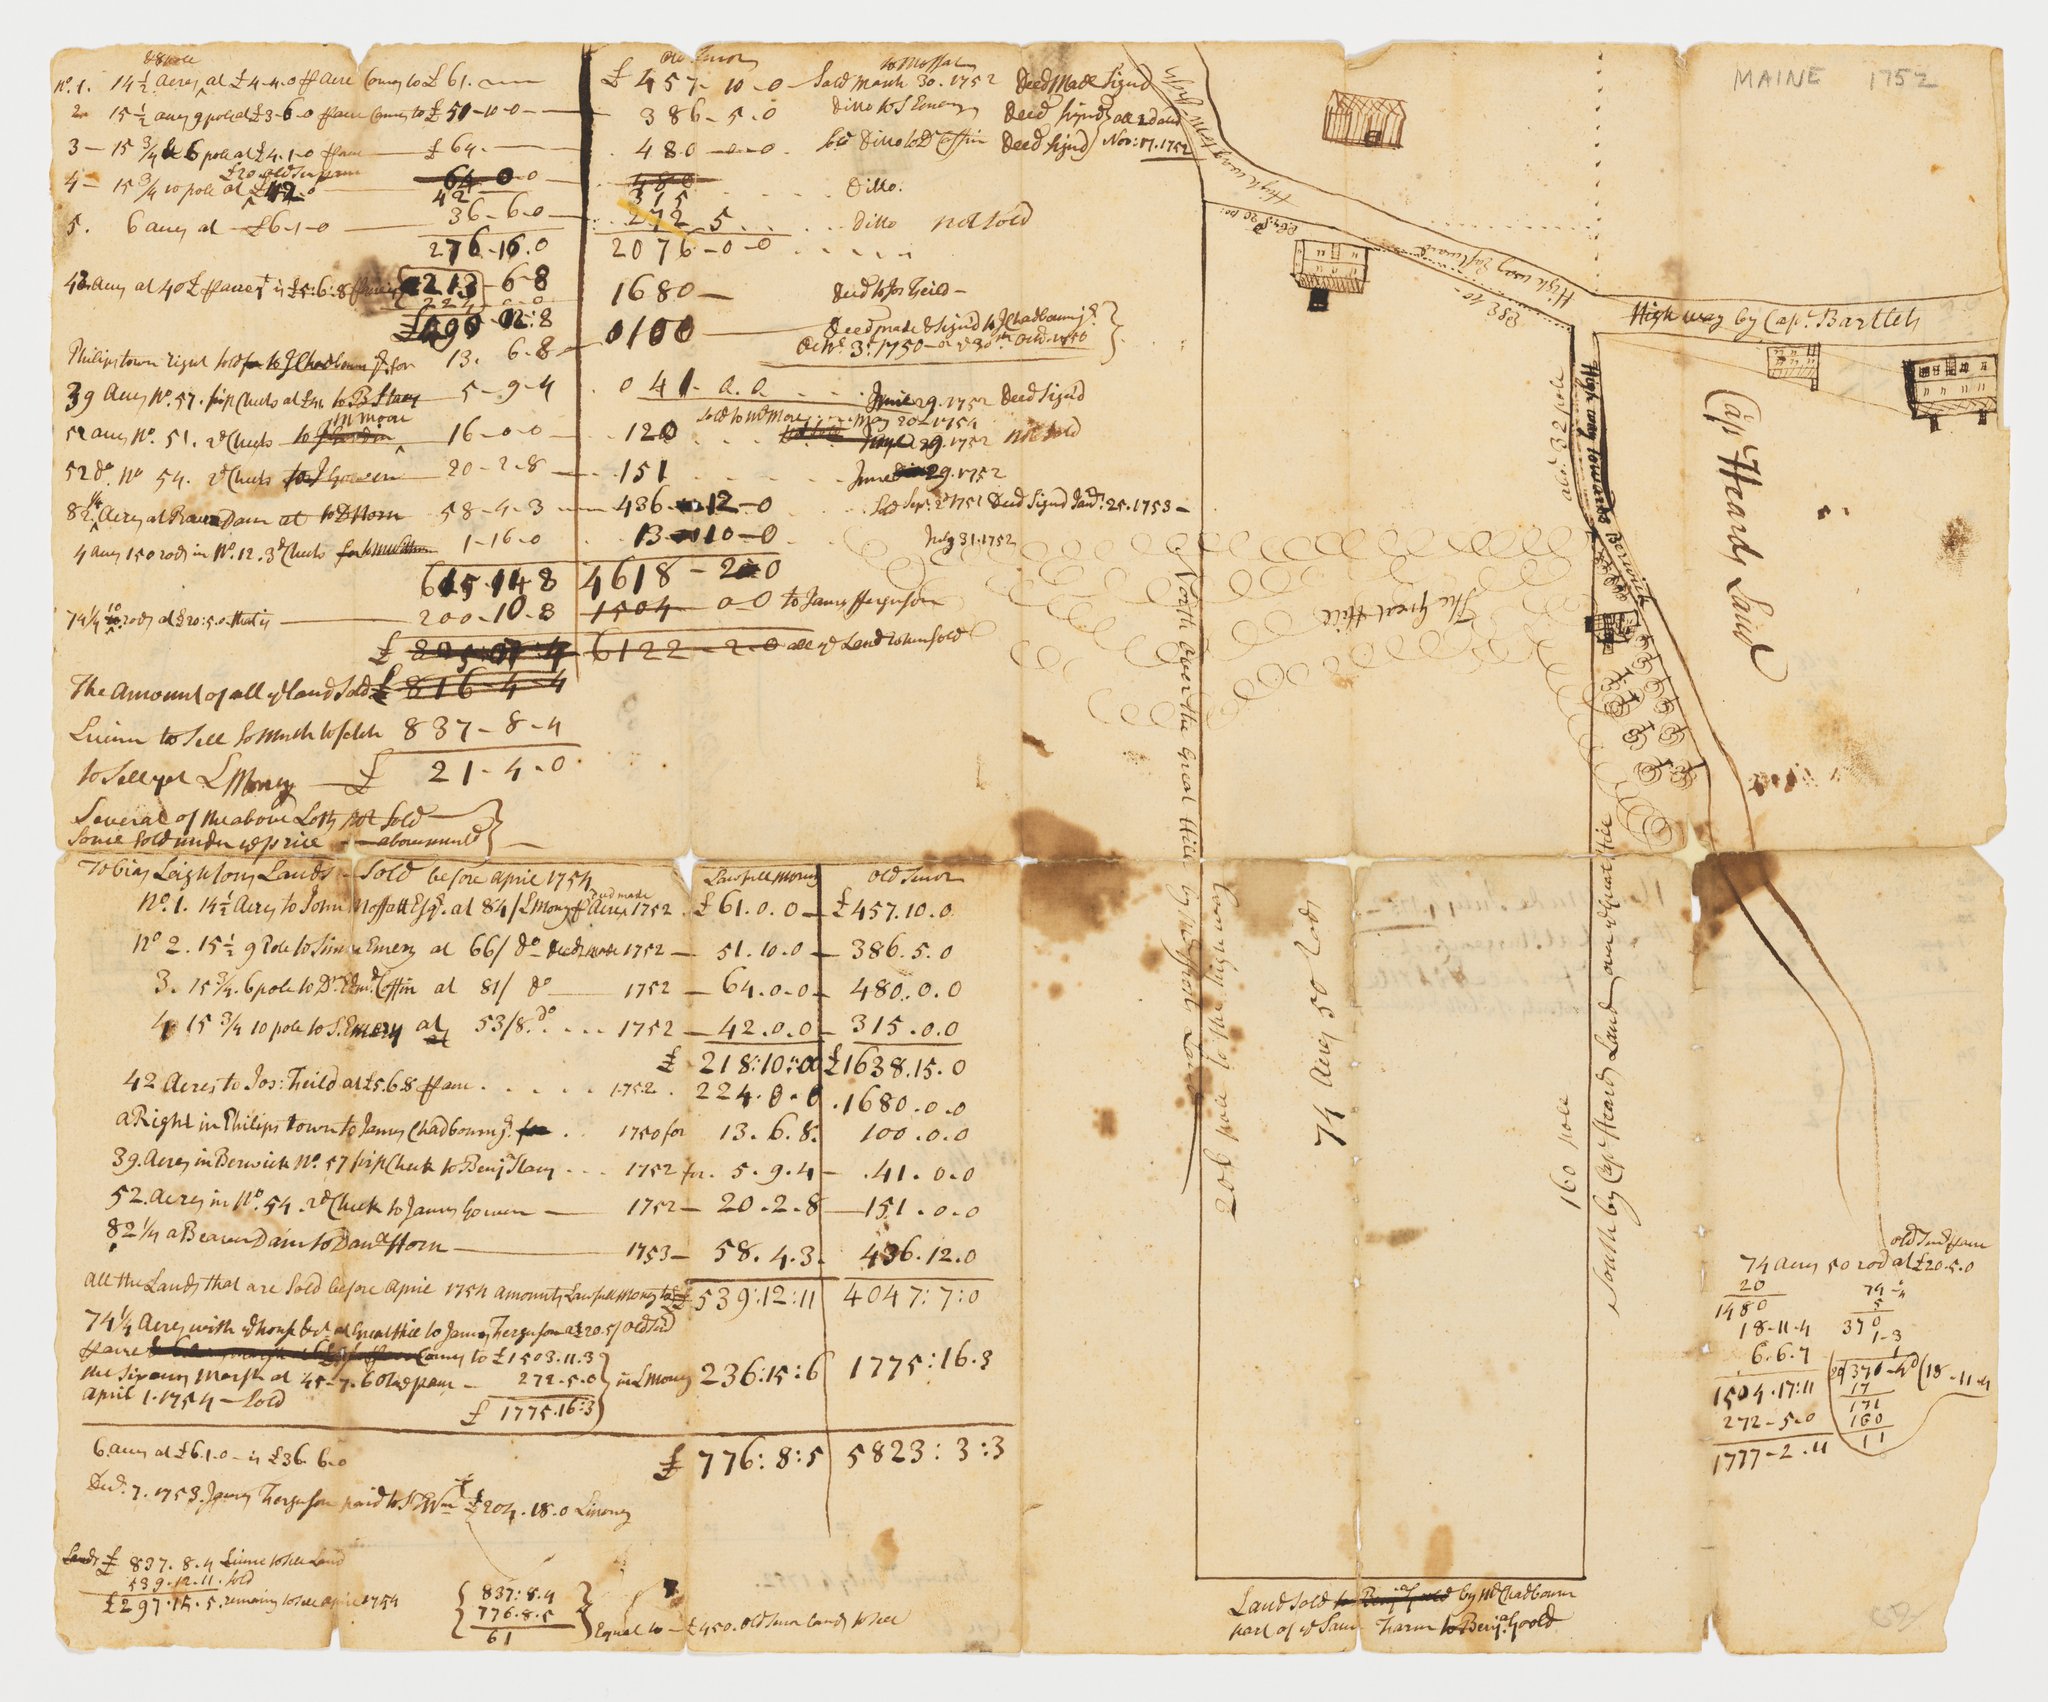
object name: drawing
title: Survey of Sturgeon Creek, Maine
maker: anonymous, american, 18th century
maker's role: artist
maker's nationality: american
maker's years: 1700-1800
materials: ink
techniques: pen